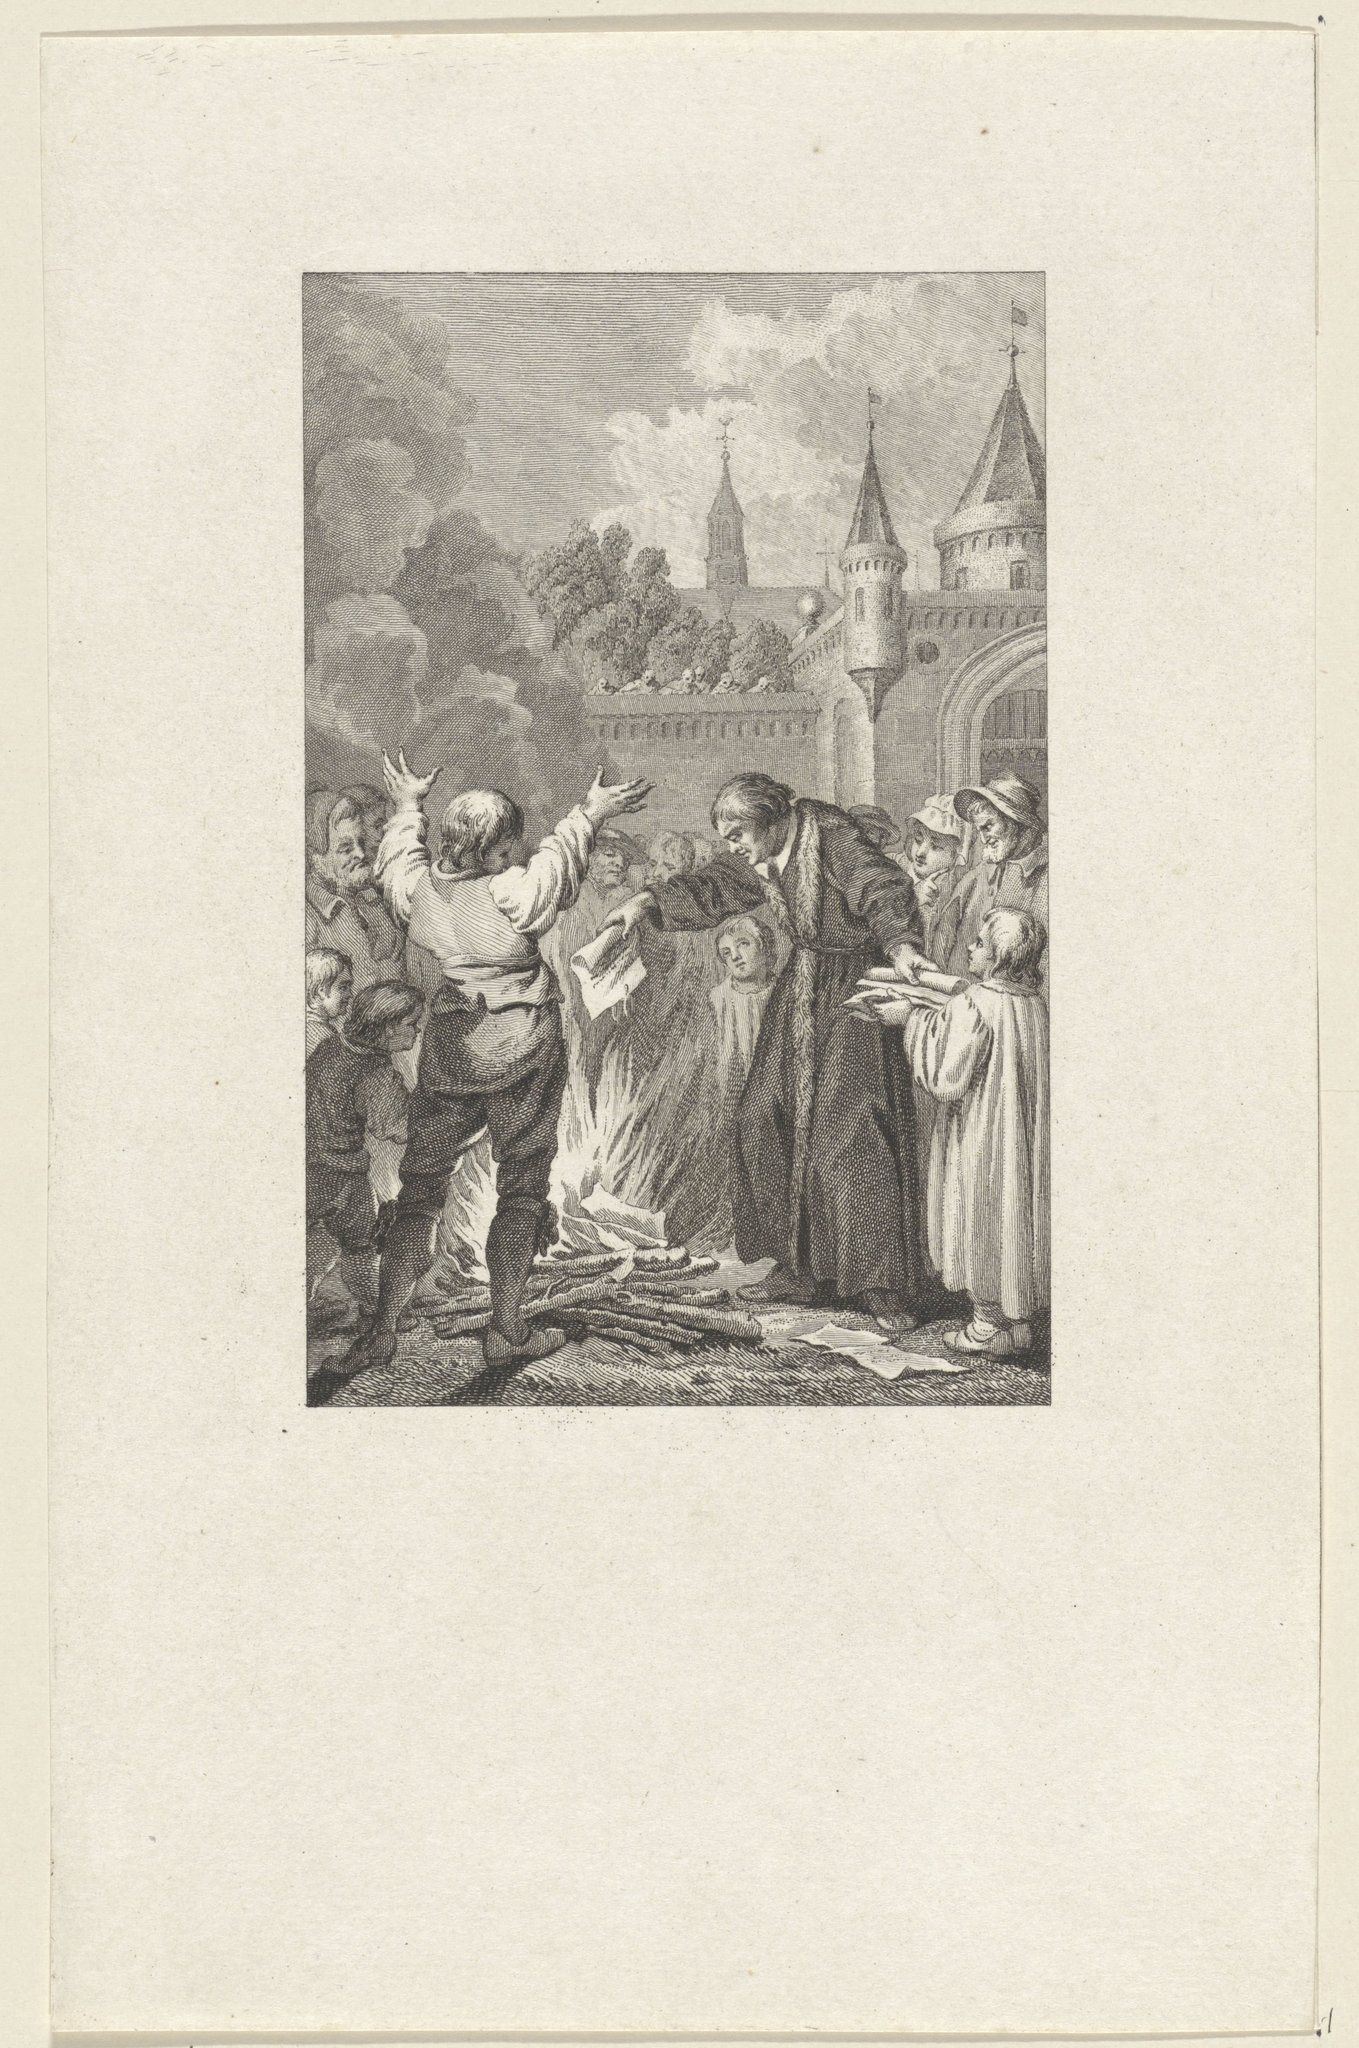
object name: print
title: Martin Luther verbrandt de pauseijke bul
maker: reinier vinkeles (i)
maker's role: draughtsman, print maker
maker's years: 1741-1816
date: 1783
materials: paper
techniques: engraving, etching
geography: amsterdam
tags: priest, martin luther, burning of books (+ variant)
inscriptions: collector's mark: Lugt 240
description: Latere staat prent gebruikt als boekillustratie in: Martinet, Joannes Florentius. Historie der waereld. Amsterdam: Johannes Allart, 1780-1788. 25 delen. deel IV, pl. I.